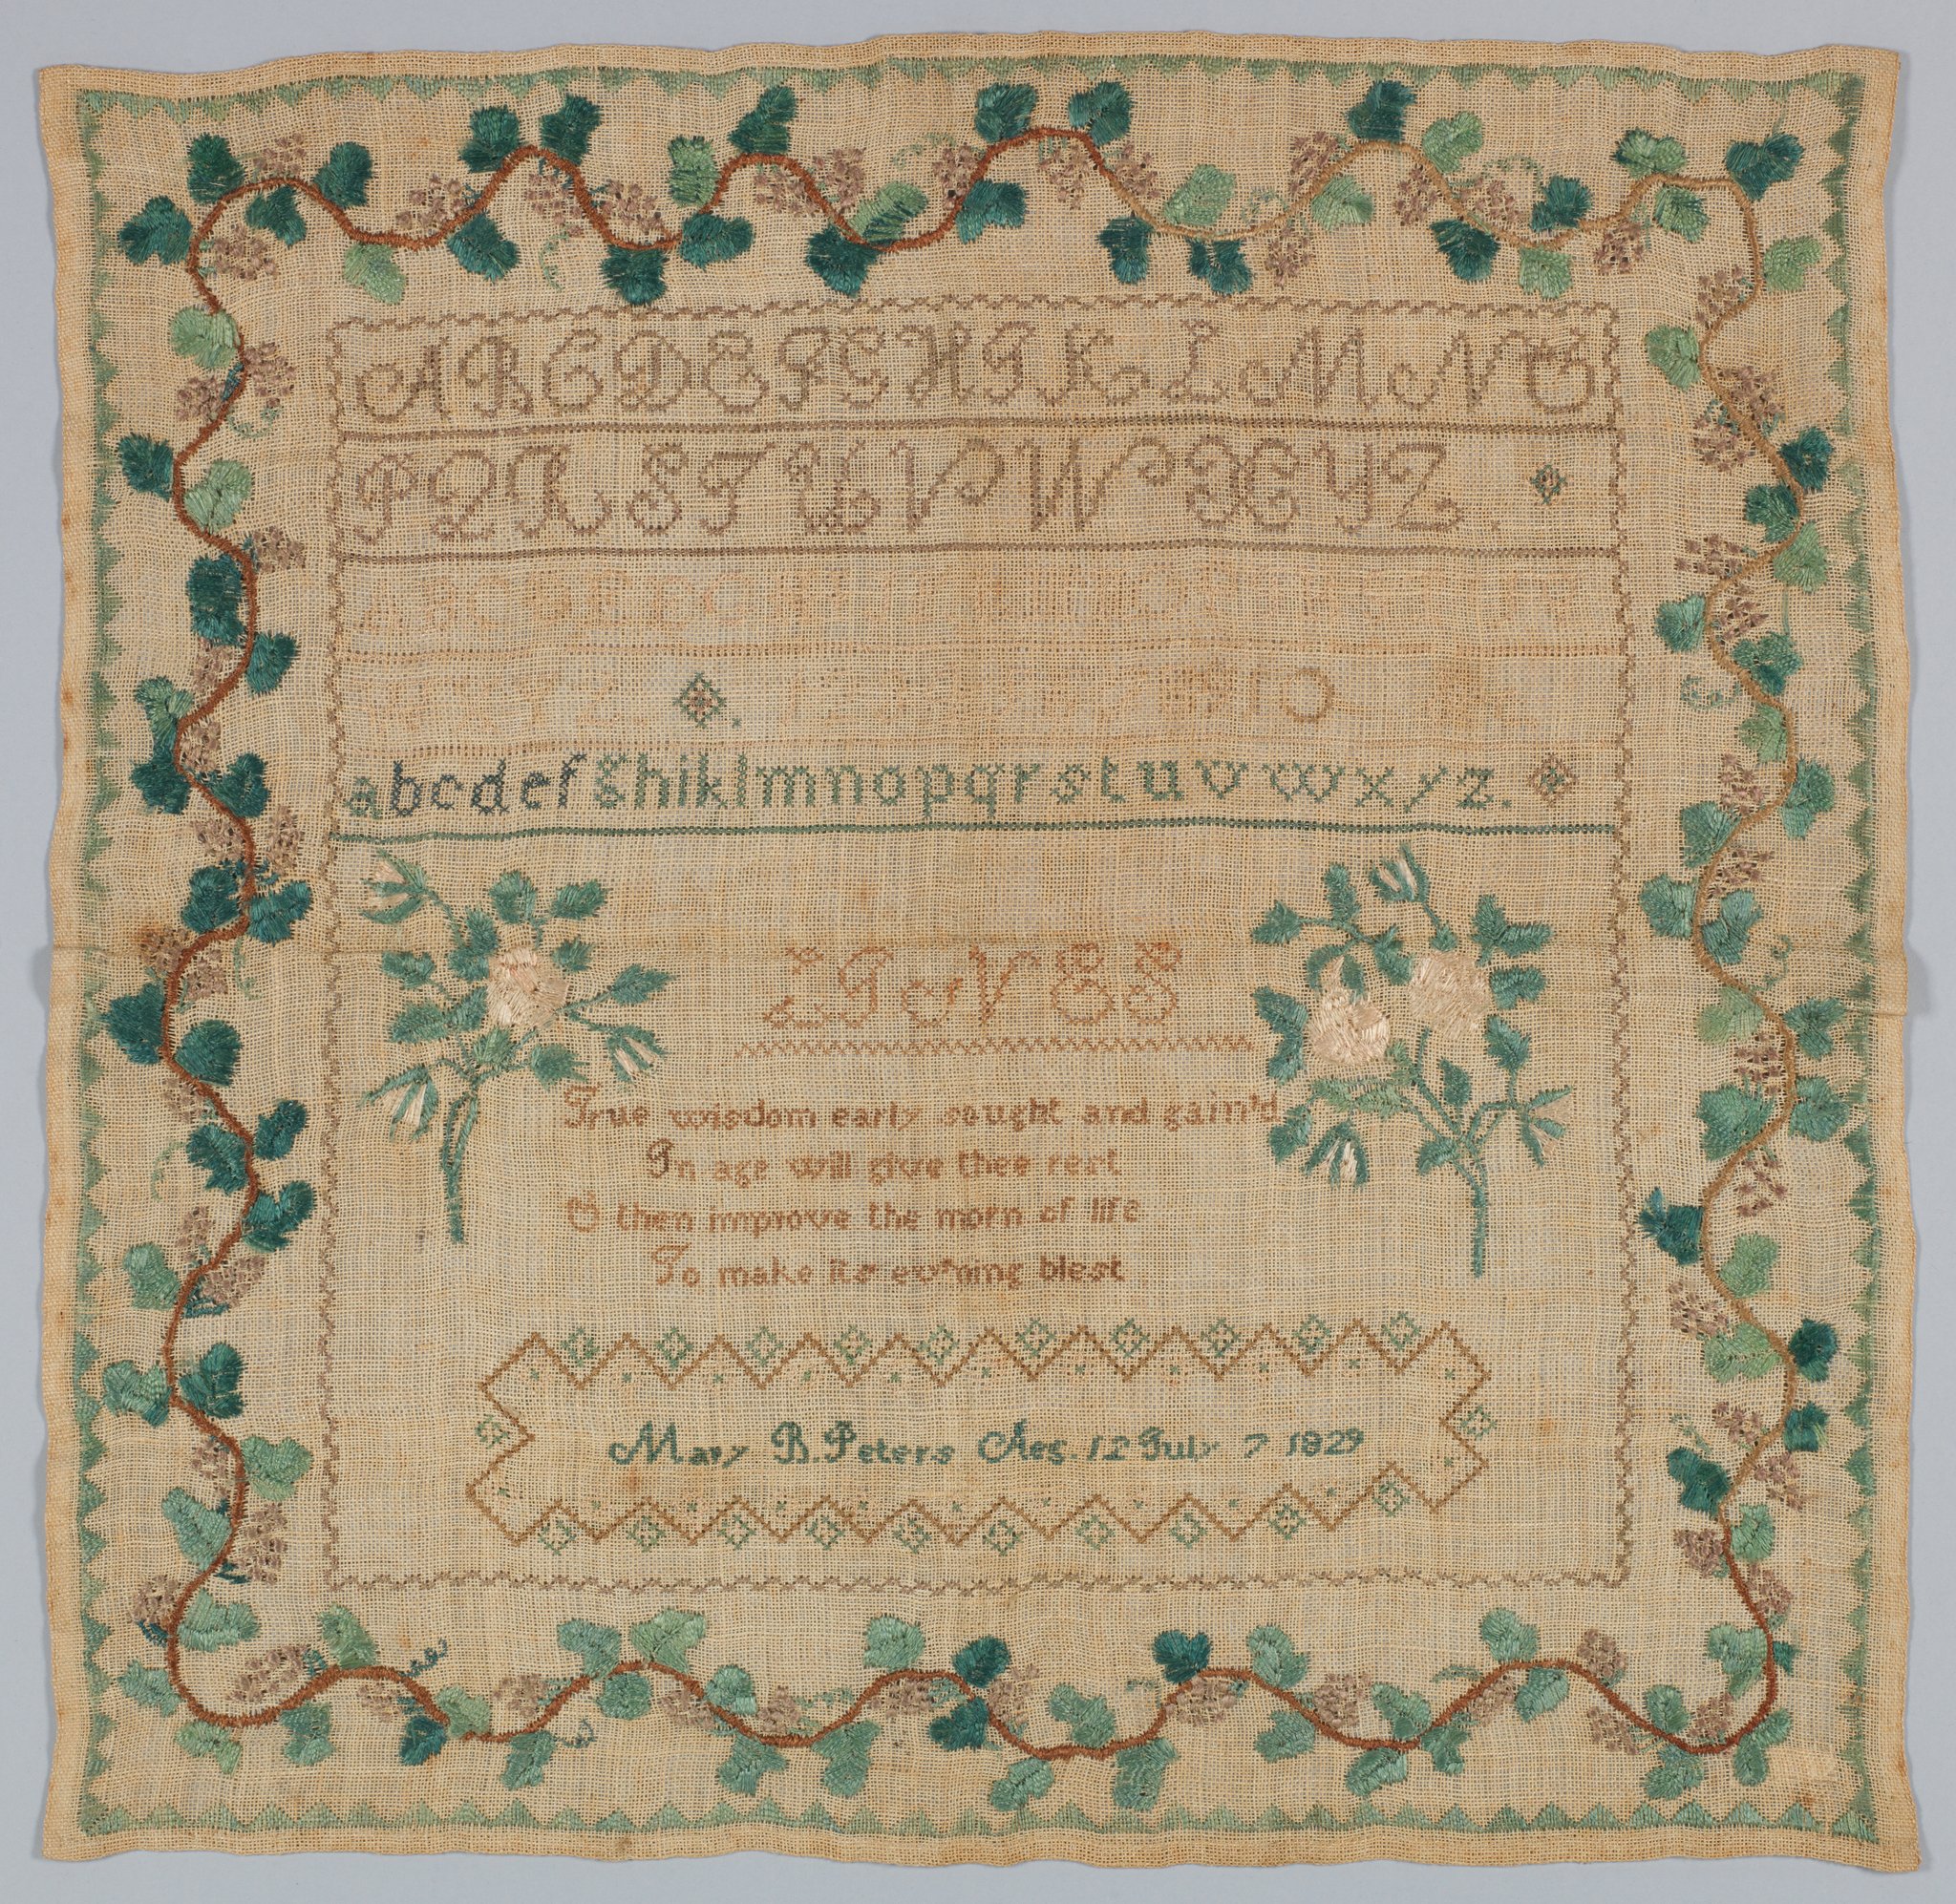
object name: sampler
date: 1829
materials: canvas, linen, silk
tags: flowers